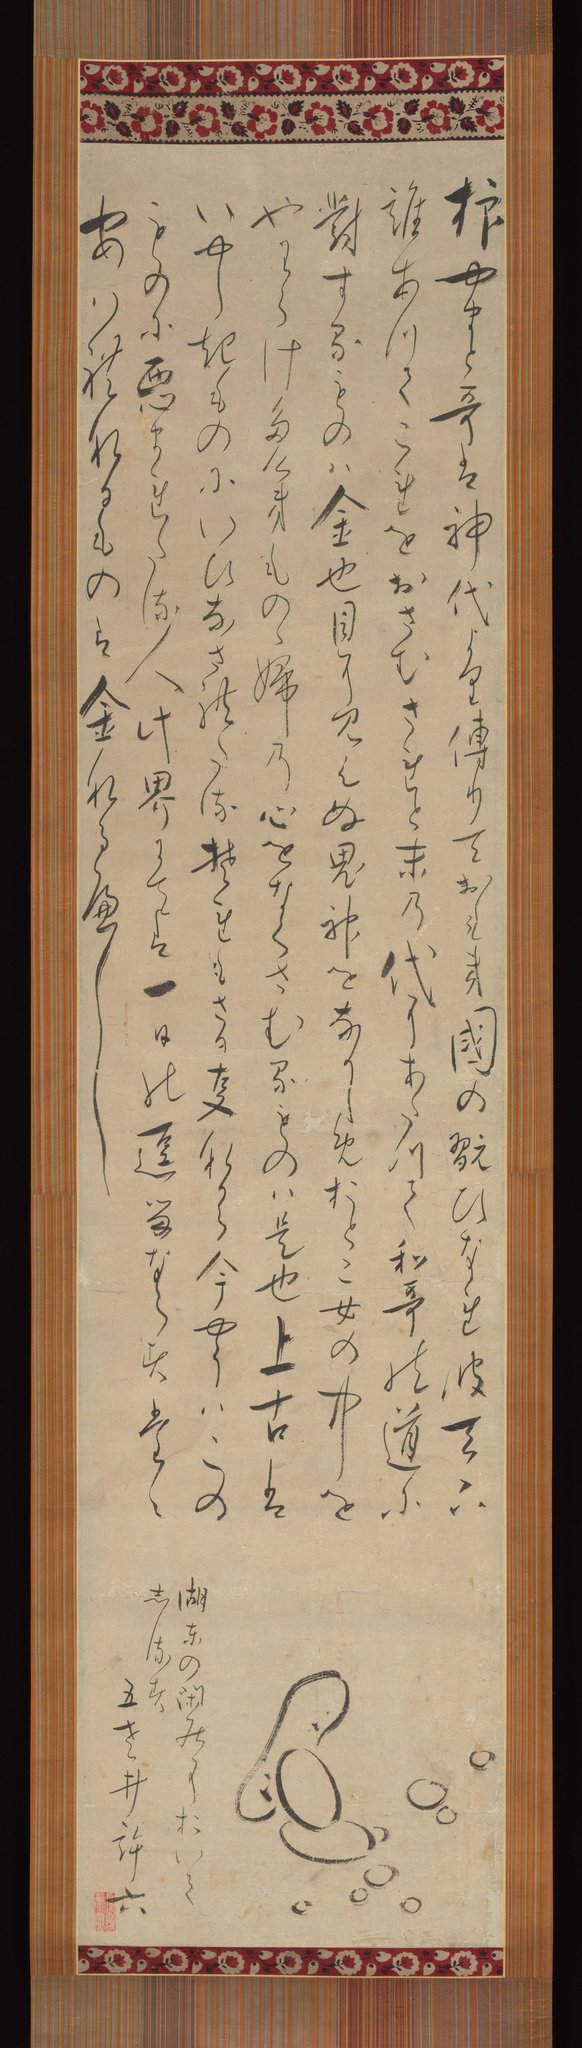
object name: hanging scroll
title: Passage from “A Modern-Day Wen Xuan: Selections of Refined Literature”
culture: japanese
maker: morikawa kyoriku (kyoroku) 森川許六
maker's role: artist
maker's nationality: japanese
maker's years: 1656-1715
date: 1705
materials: ink, paper